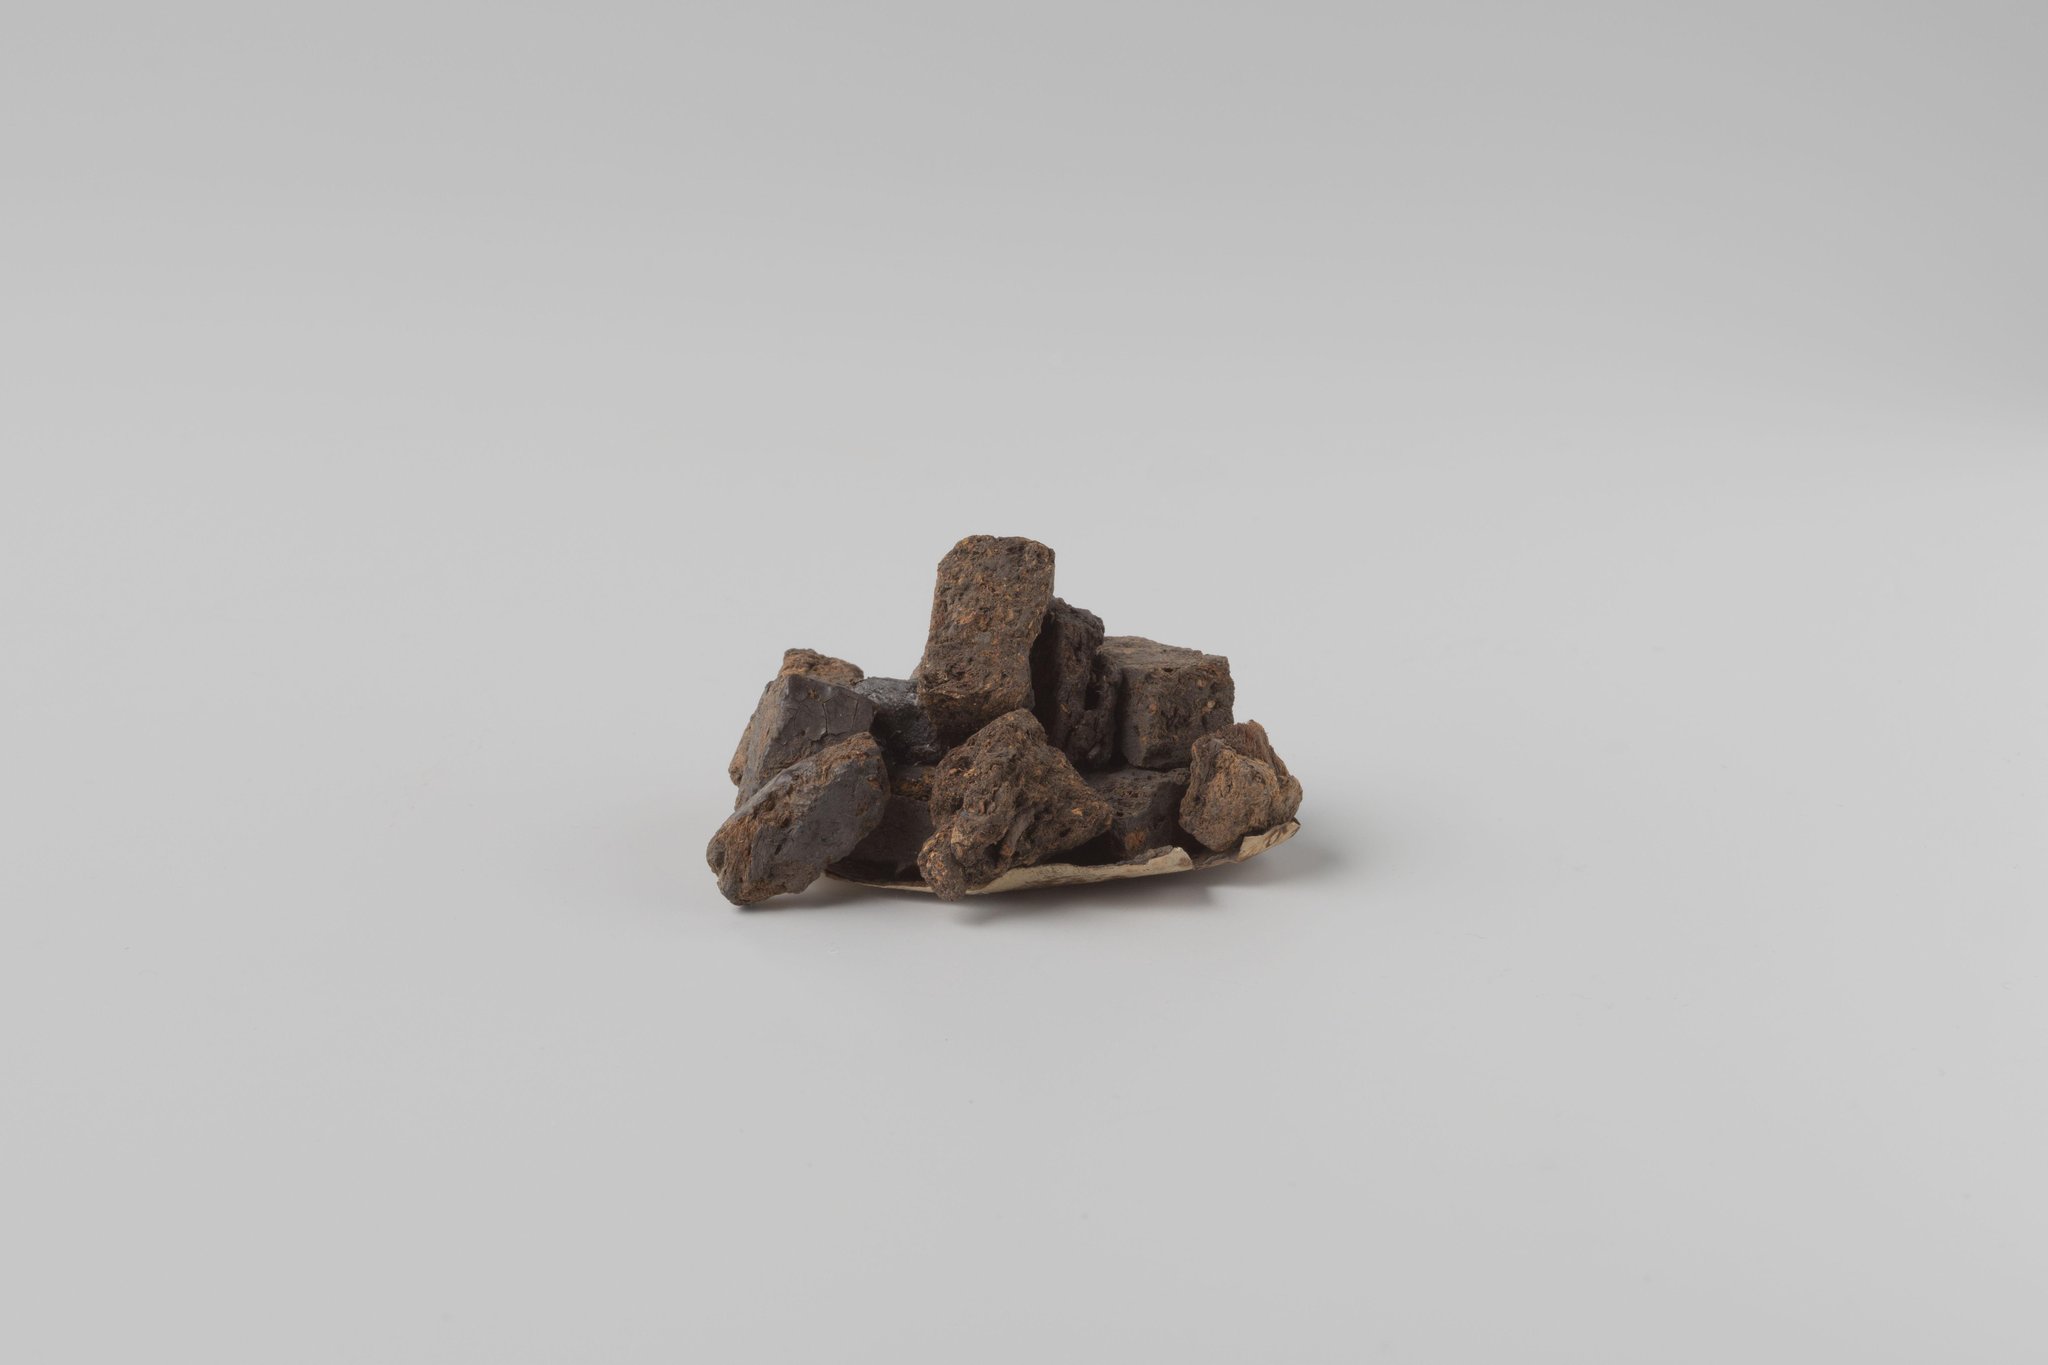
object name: miniature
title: Turfblokken, opgestapeld op een stuk papier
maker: Anonymous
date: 1676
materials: paper, peat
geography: amsterdam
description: Turfblokken, opgestapeld op een stuk papier (deel van een schrijfoefening van de letters f, d en c in 17de eeuws schrift).